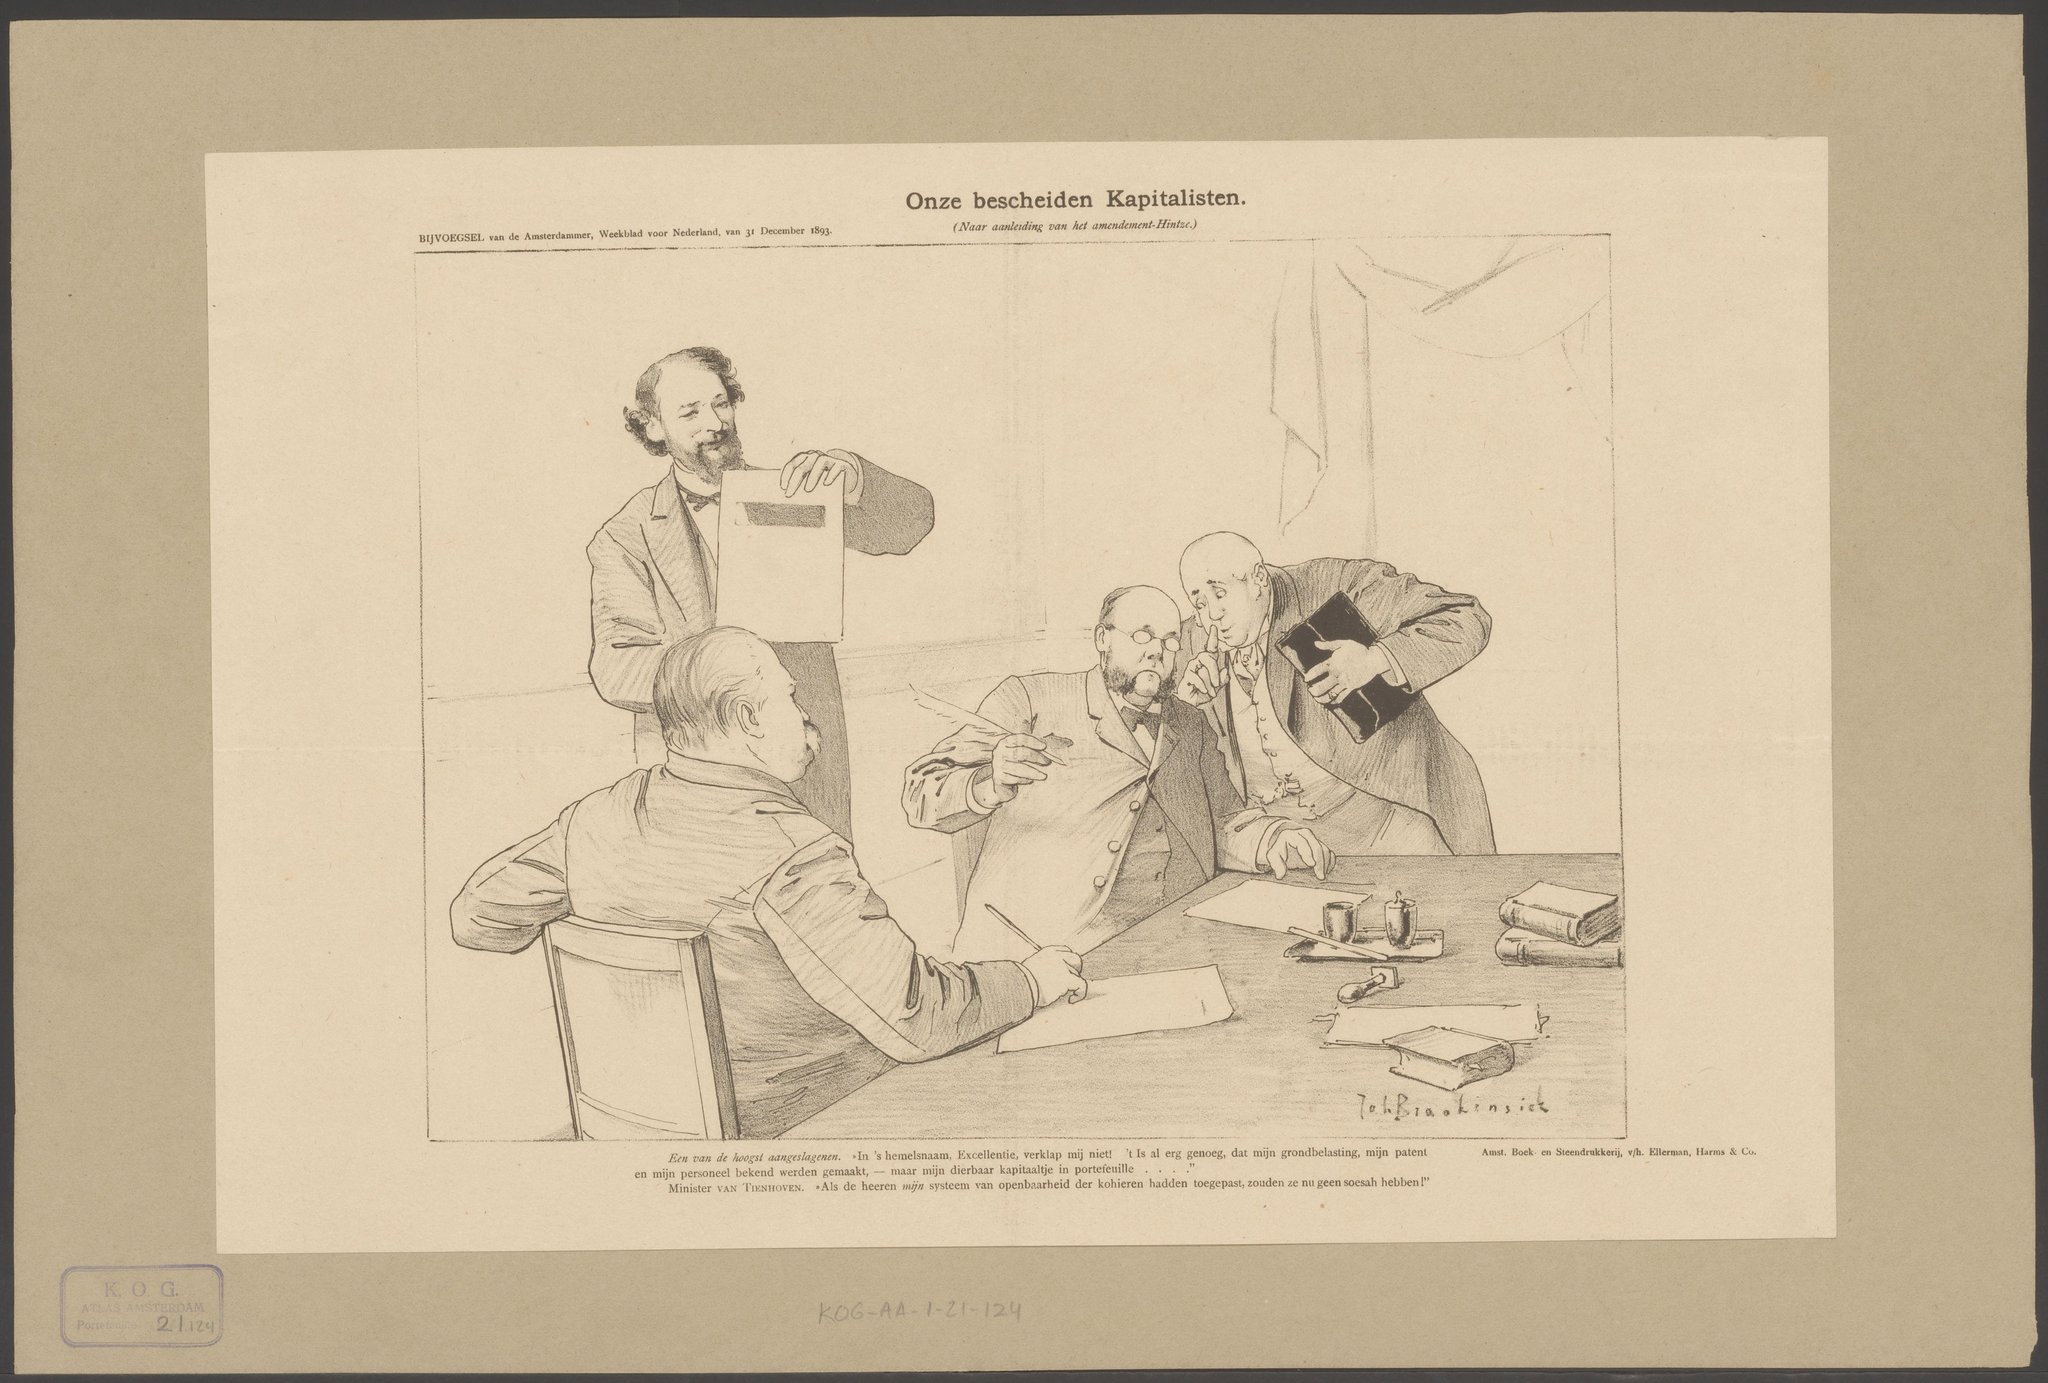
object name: cartoon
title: Onze bescheiden Kapitalisten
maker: johan braakensiek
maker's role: draughtsman, print maker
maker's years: 1858-1940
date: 1893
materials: paper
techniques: letterpress printing, lithograph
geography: amsterdam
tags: amsterdam, politician, nicolaas gerard pierson, mayor, gijsbert van tienhoven, tax collection, financial administration ~ taxes, politician, e.g. party leader, government, the state; 'politica', 'auttorità o potestà' (ripa), municipal government, political caricatures and satires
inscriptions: collector's mark: Lugt 1641b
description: Pierson, minister van Financiën, als ondertekenaar. Links minister van Buitenlandse Zaken Gijsbert van Tienhoven die een map omhooghoudt. Onderwerpsrubriek binnen de Atlas Amsterdam: Belastingen.